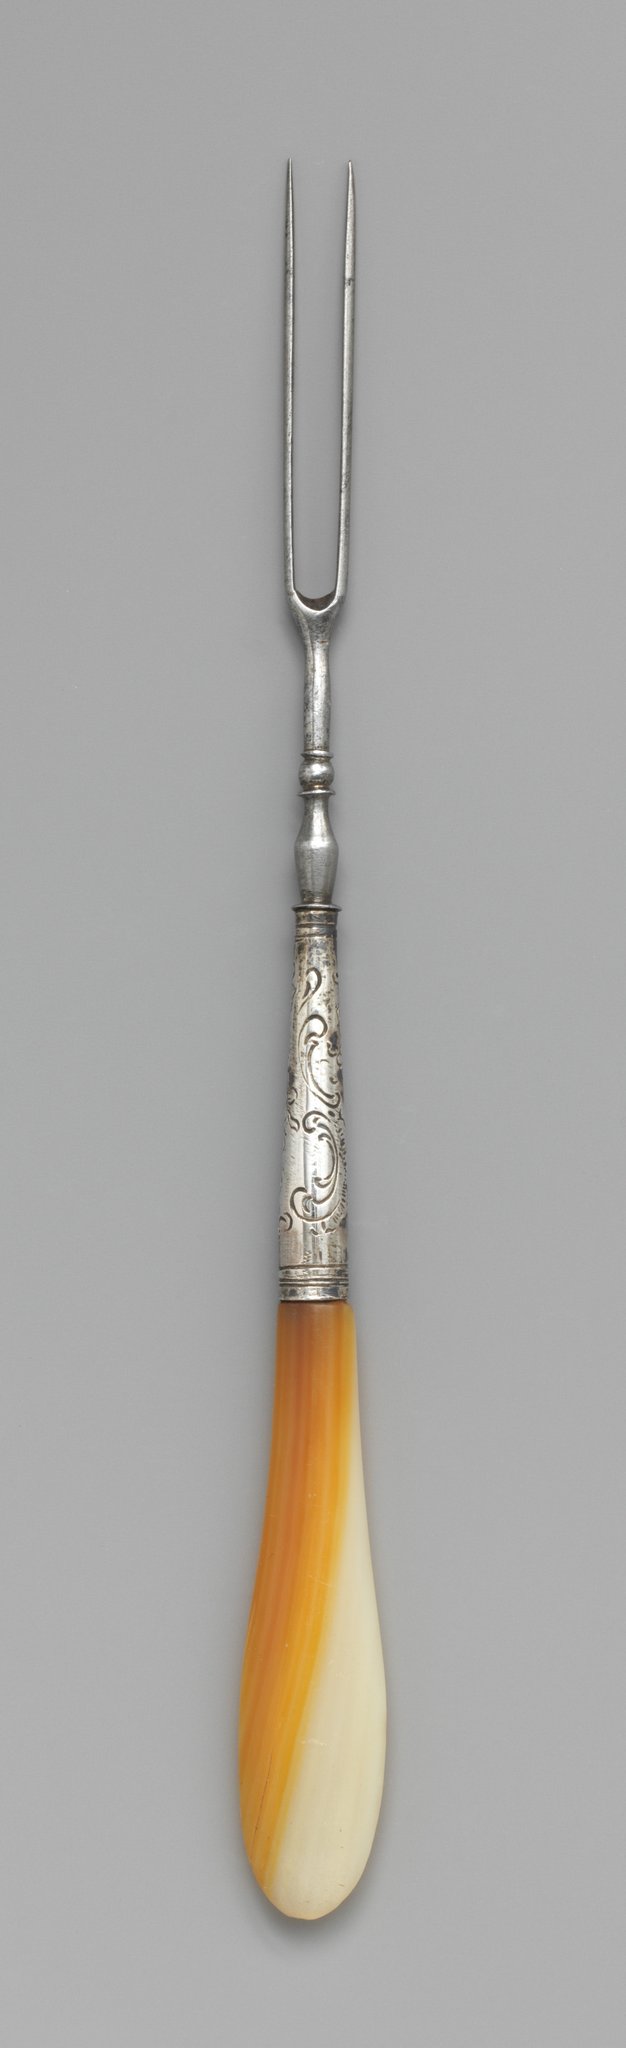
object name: fruit fork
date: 1701-1800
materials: mother of pearl, steel